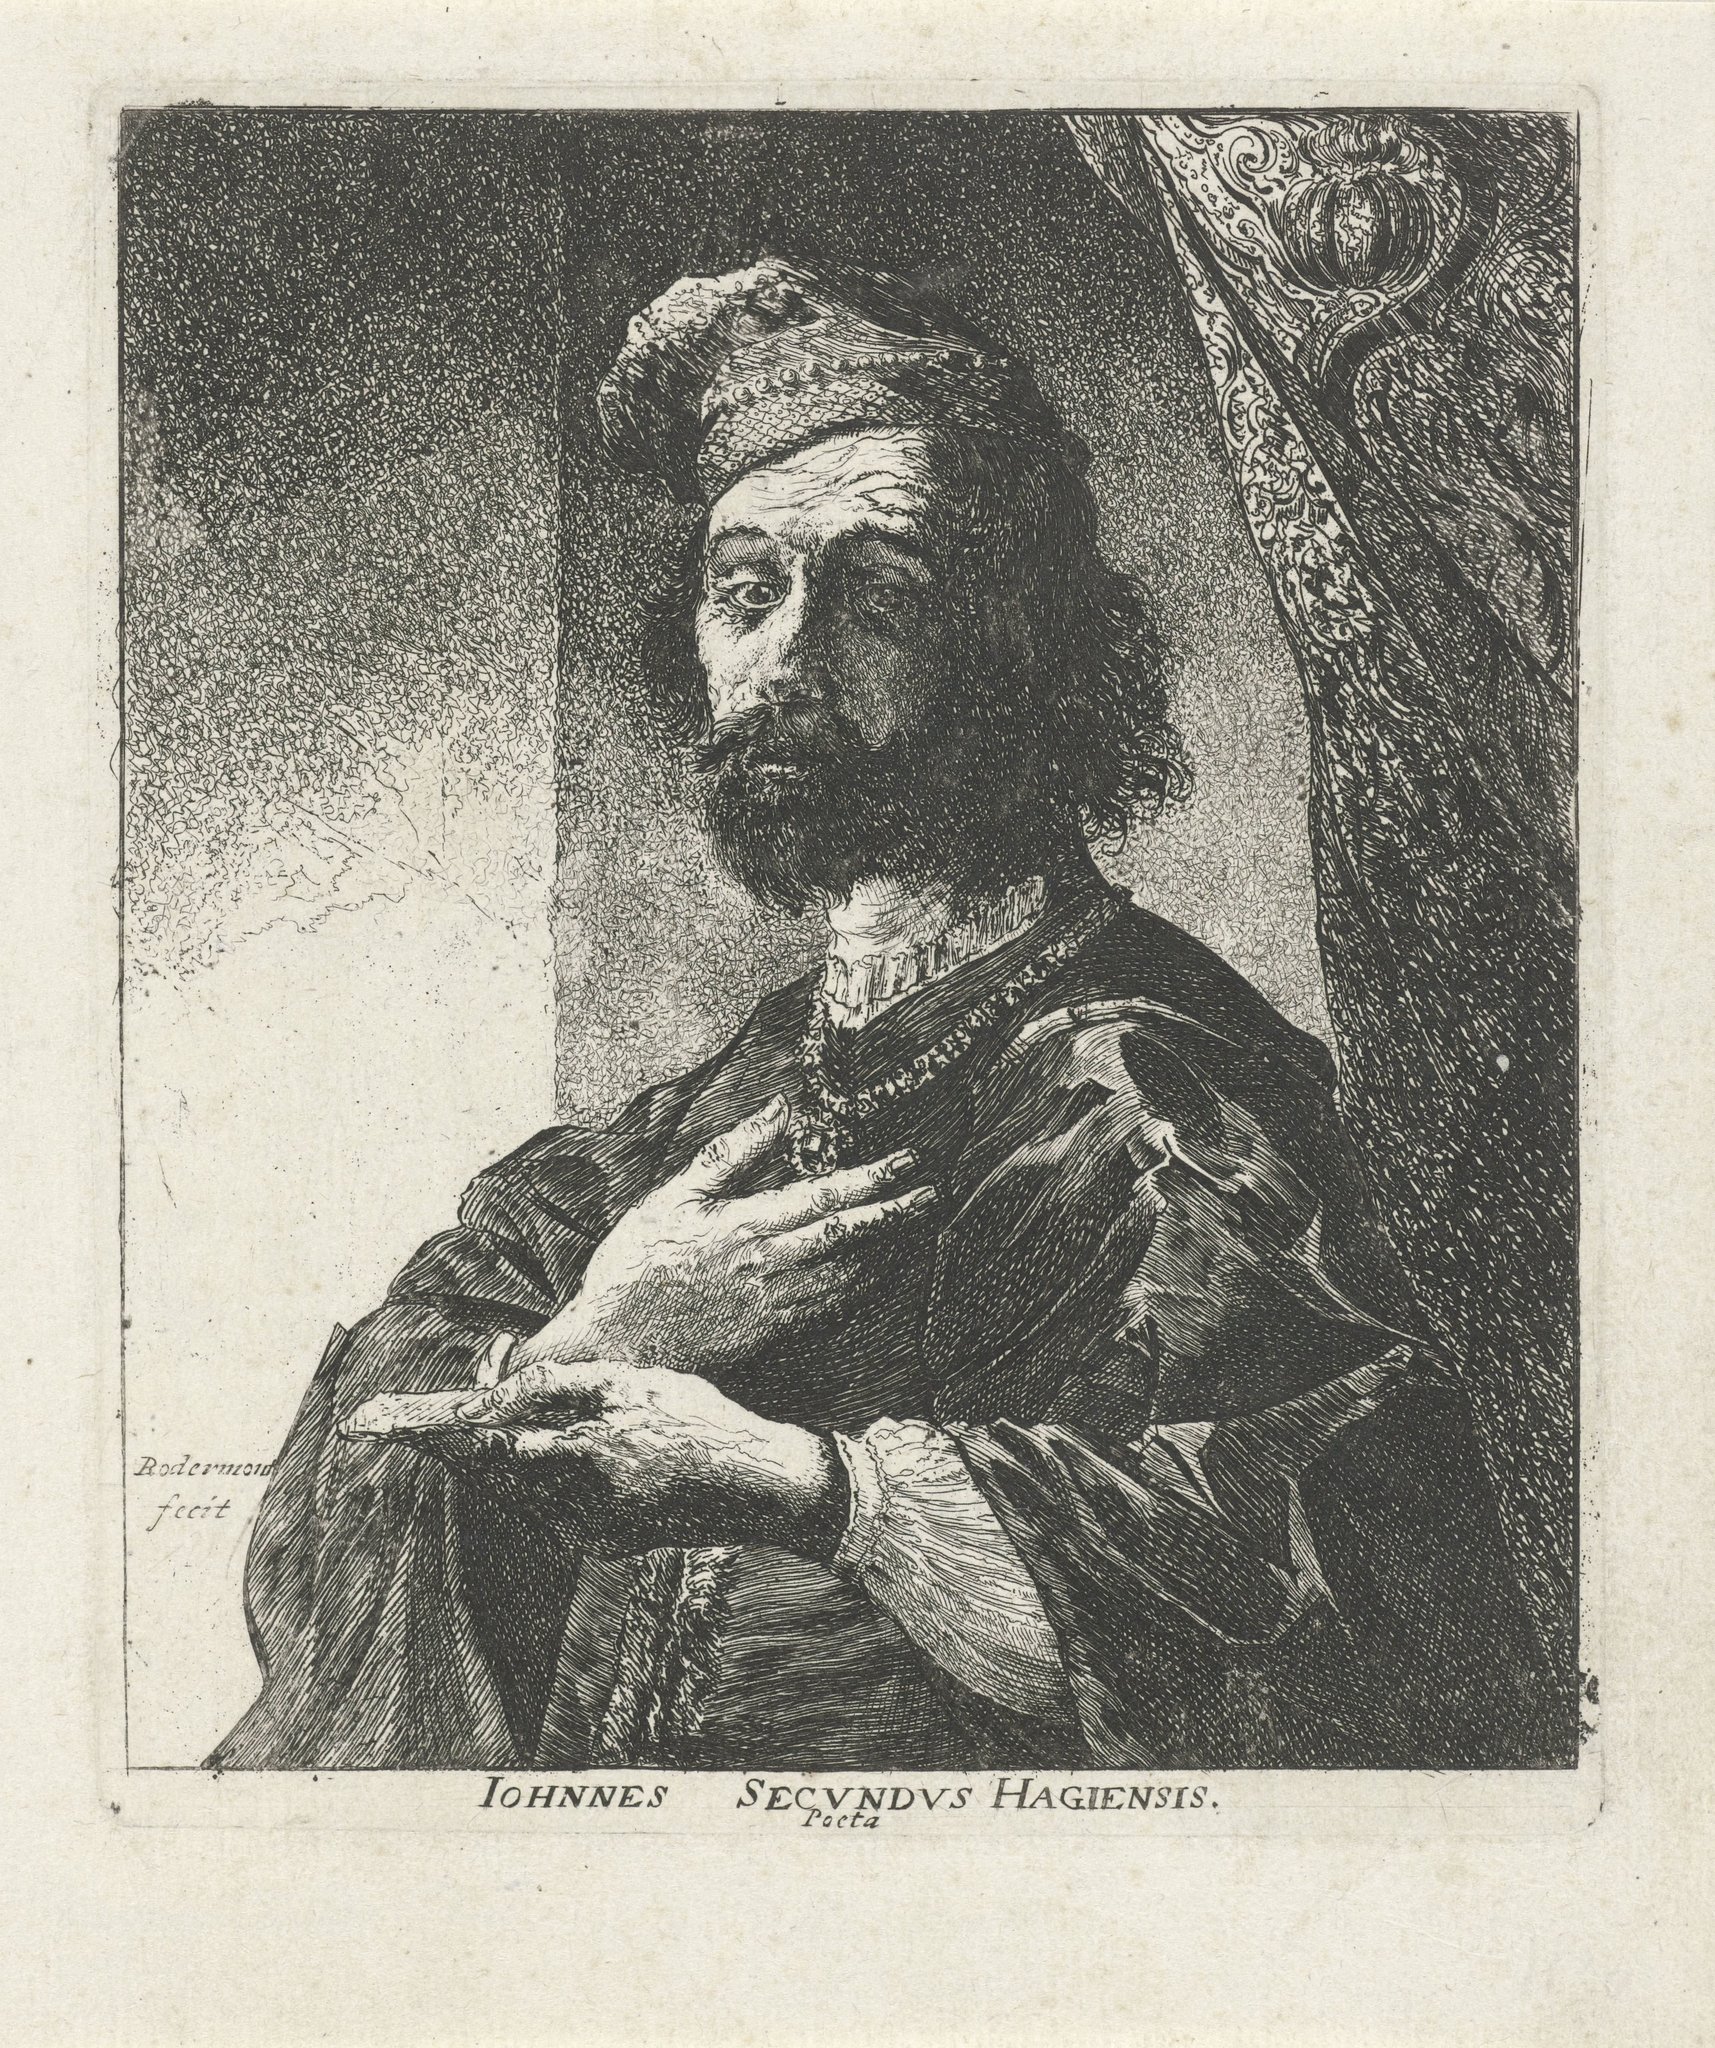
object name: print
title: Portret van Janus Secundus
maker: pieter rottermondt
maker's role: draughtsman, print maker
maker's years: -1706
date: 1639-1643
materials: paper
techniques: engraving, etching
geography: the hague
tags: the hague, janus secundus, writer, poet, author (+ portrait, self-portrait of artist), head-gear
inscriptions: collector's mark: Lugt 2166, collector's mark: Lugt 2760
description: Portret van de Nederlandse humanistische dichter Janus Secundus Nicolai Hagiensis, ook Jan Everaerts genoemd. In zijn hand houdt hij een gedicht. Hij draagt een muts.